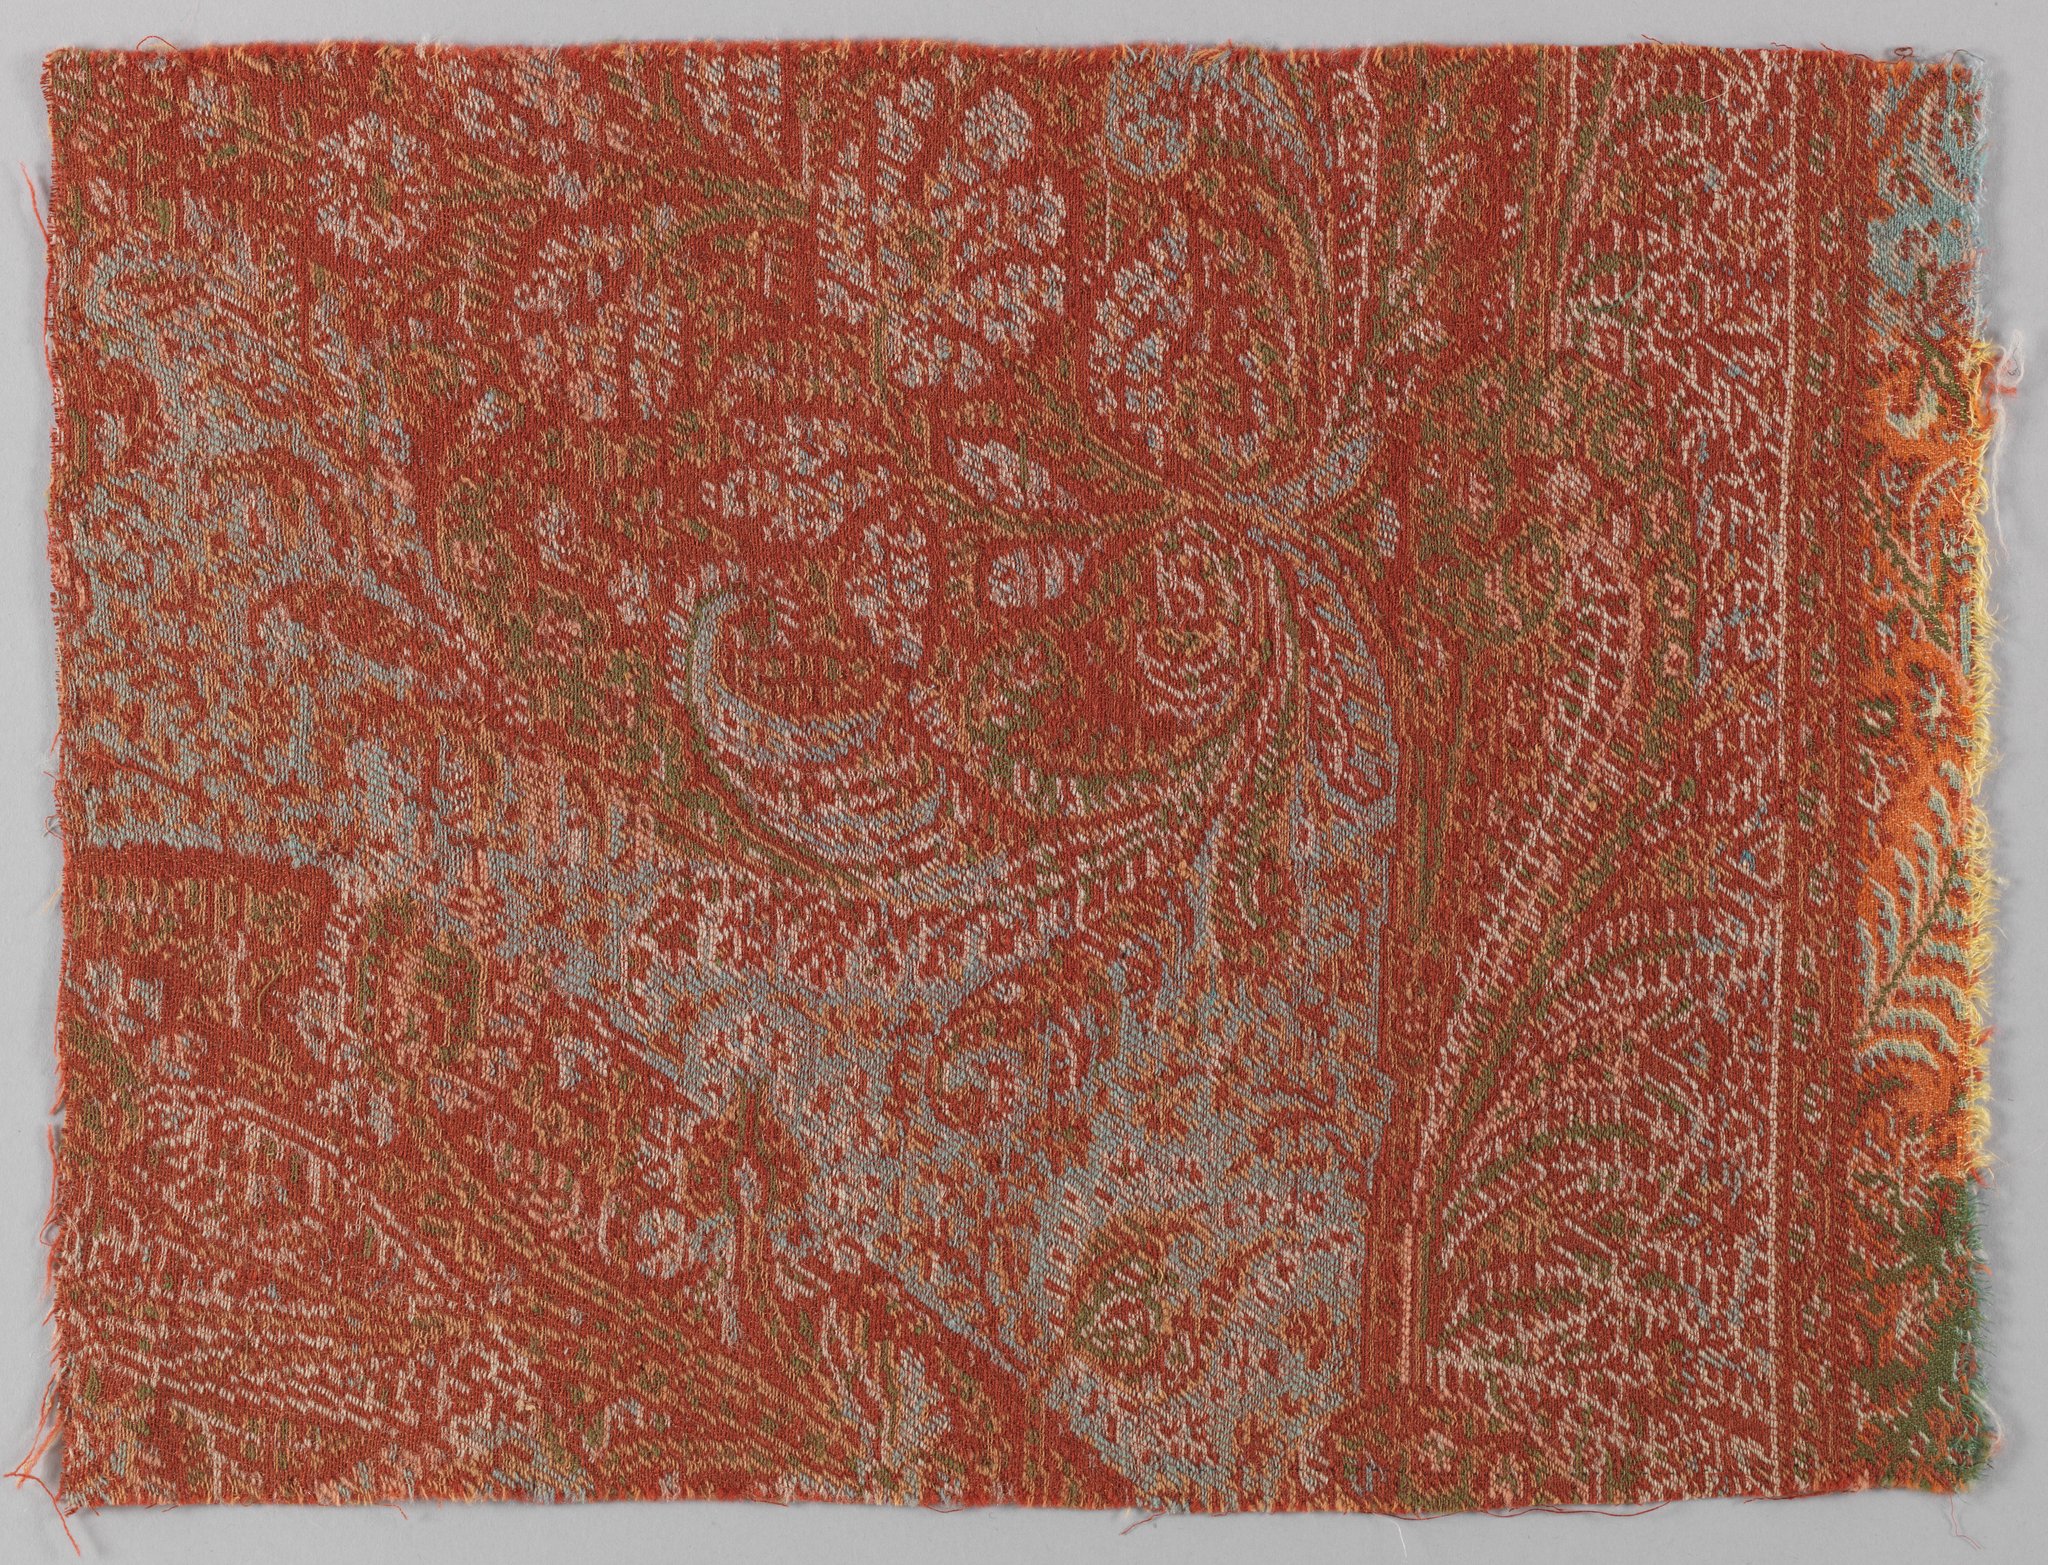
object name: piece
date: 1801-1900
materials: wool